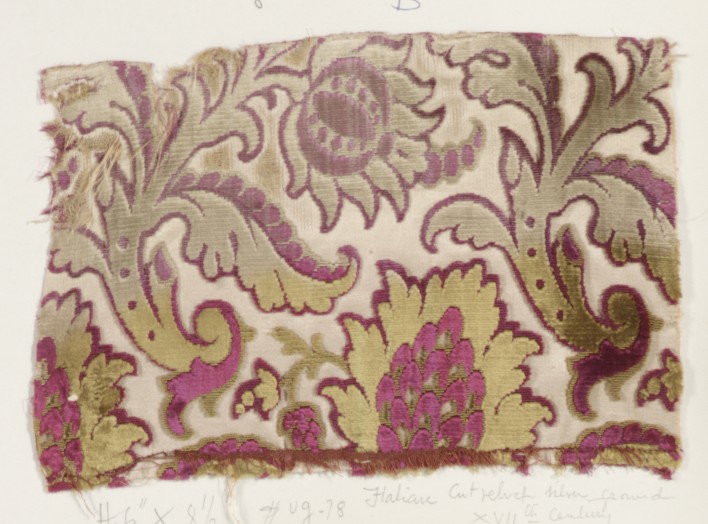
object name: fragment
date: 1601-1700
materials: silk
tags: flowers,leaves